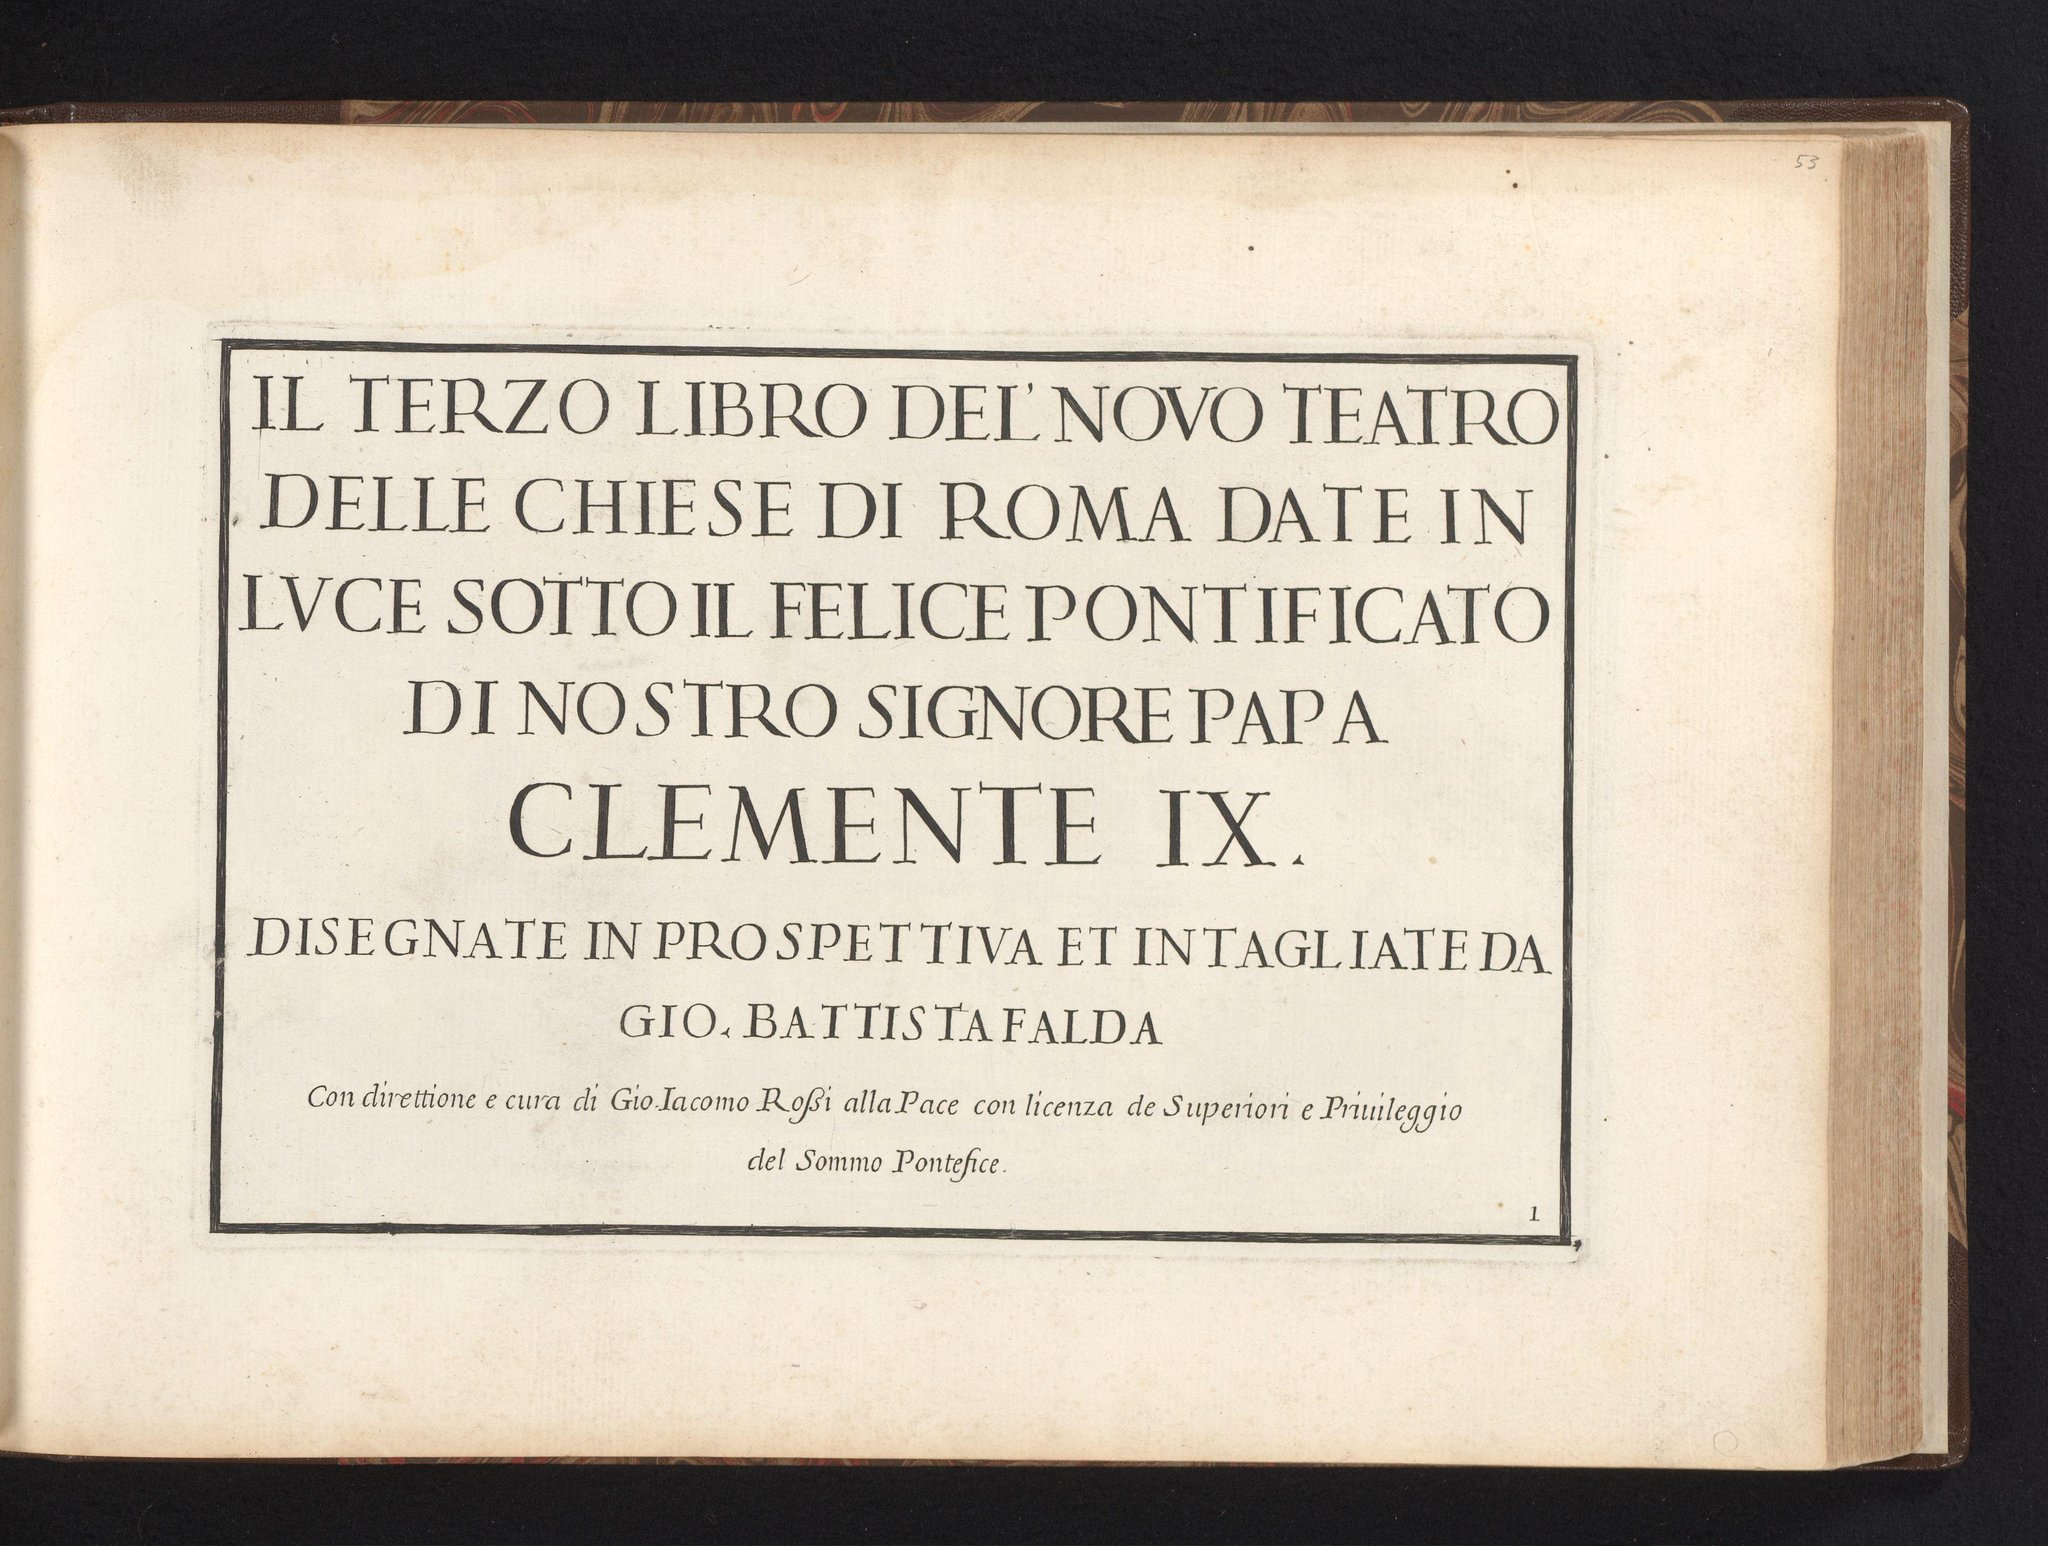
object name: titelprent, frontispice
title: Titelprent bij een reeks voorstellingen van kerken te Rome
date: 1669-1670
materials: paper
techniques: etching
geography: vatican city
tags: rome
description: Deze titelprent maakt deel uit van een reeks van 38 prenten met voorstellingen van kerken in Rome. Samen met vier andere reeksen vormt het de grote reeks: 'Il nuovo teatro di Roma moderna'.